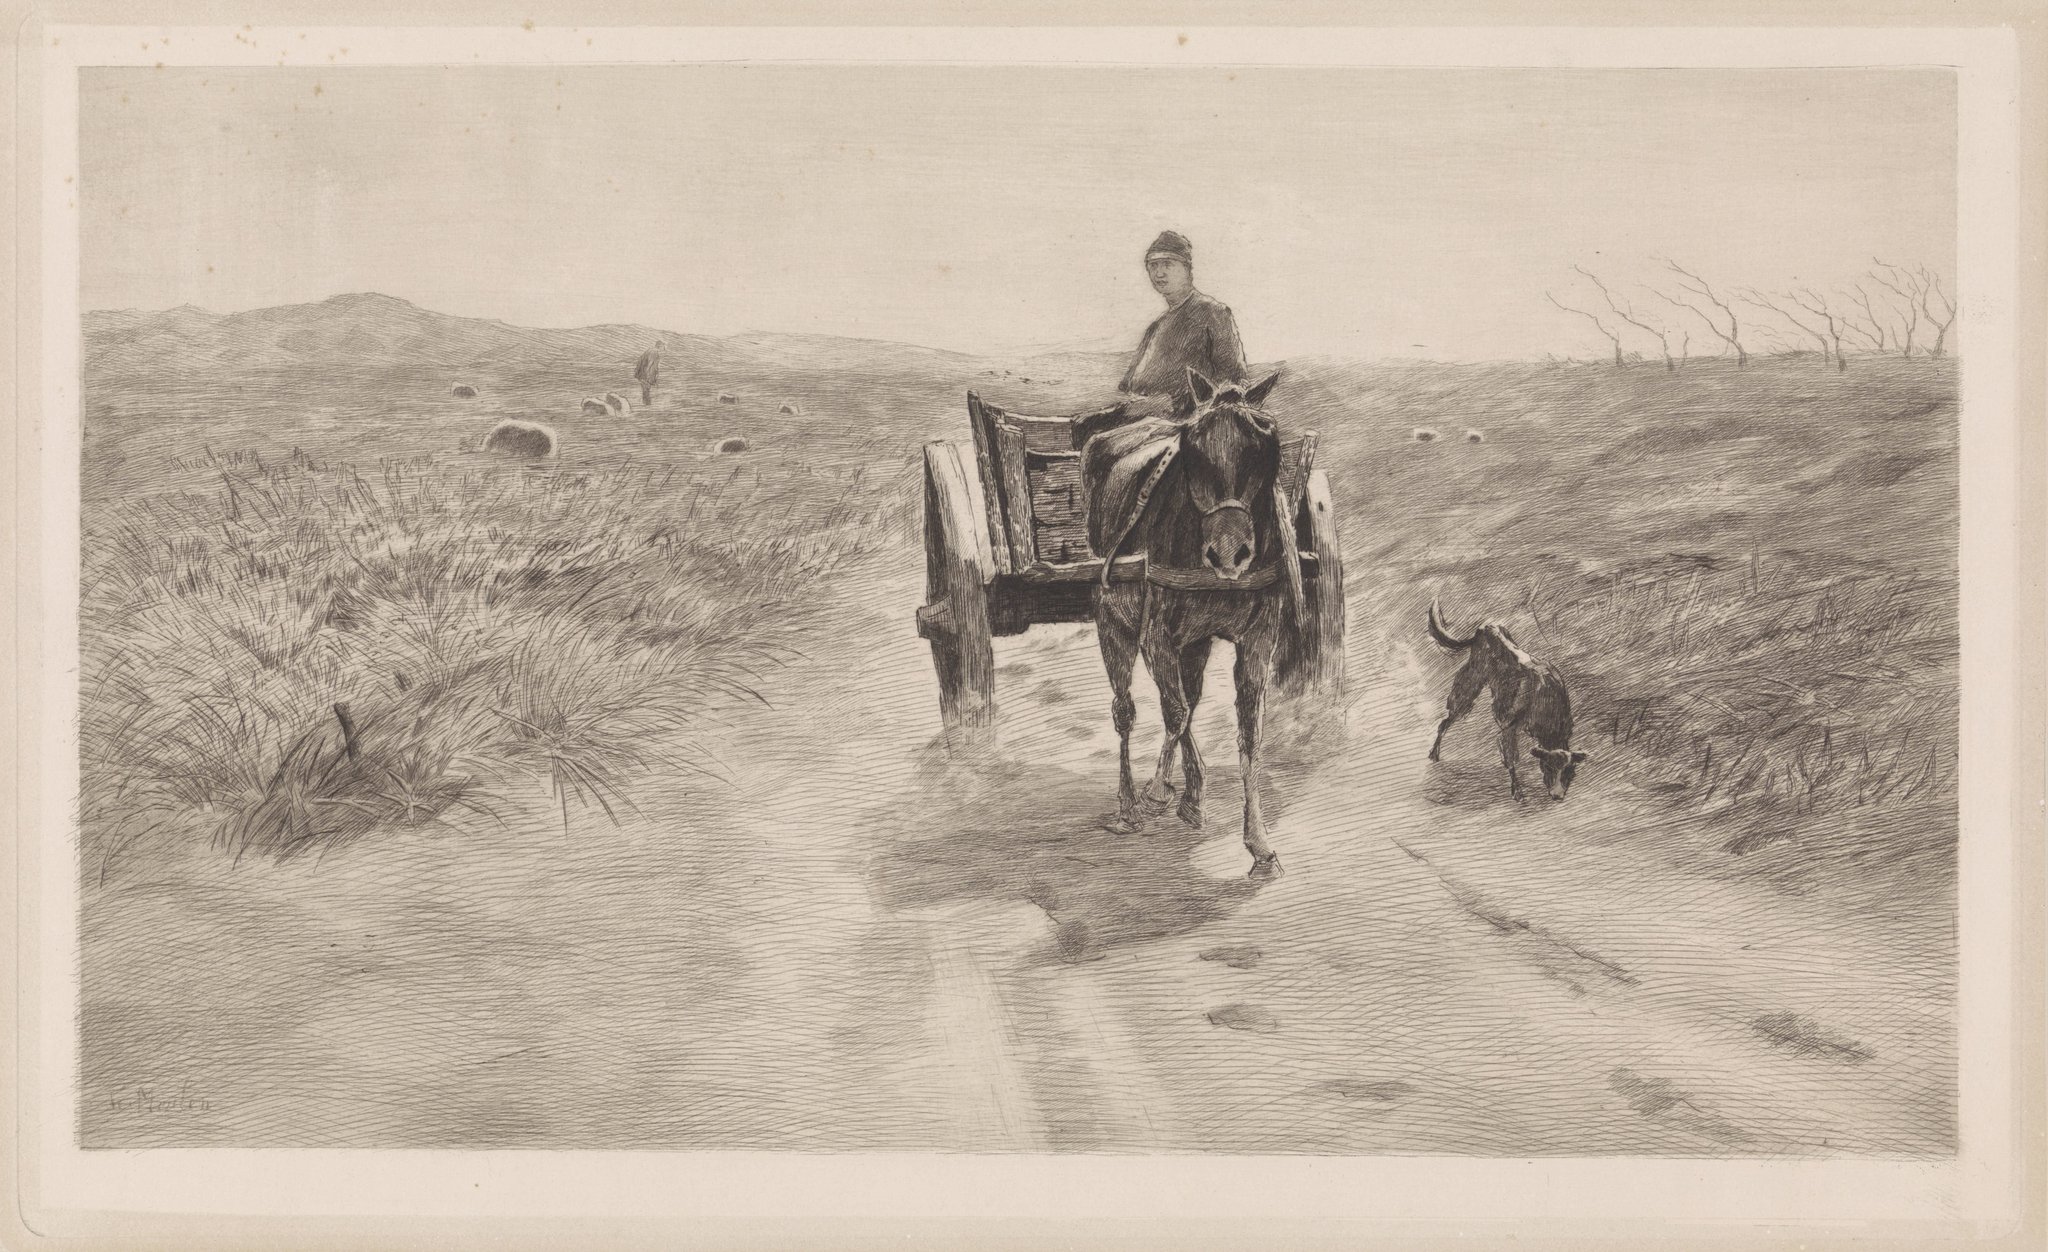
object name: print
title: Landschap met paardenkar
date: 1859-1891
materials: paper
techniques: etching, roulette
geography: netherlands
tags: horse, two-wheeled vehicle drawn by one animal, dog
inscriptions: collector's mark: Lugt 2228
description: Op een weg in een heuvelachtig landschap rijdt een door een paard getrokken kar. Op de wagen zit een man, naast de wagen loopt een hond.